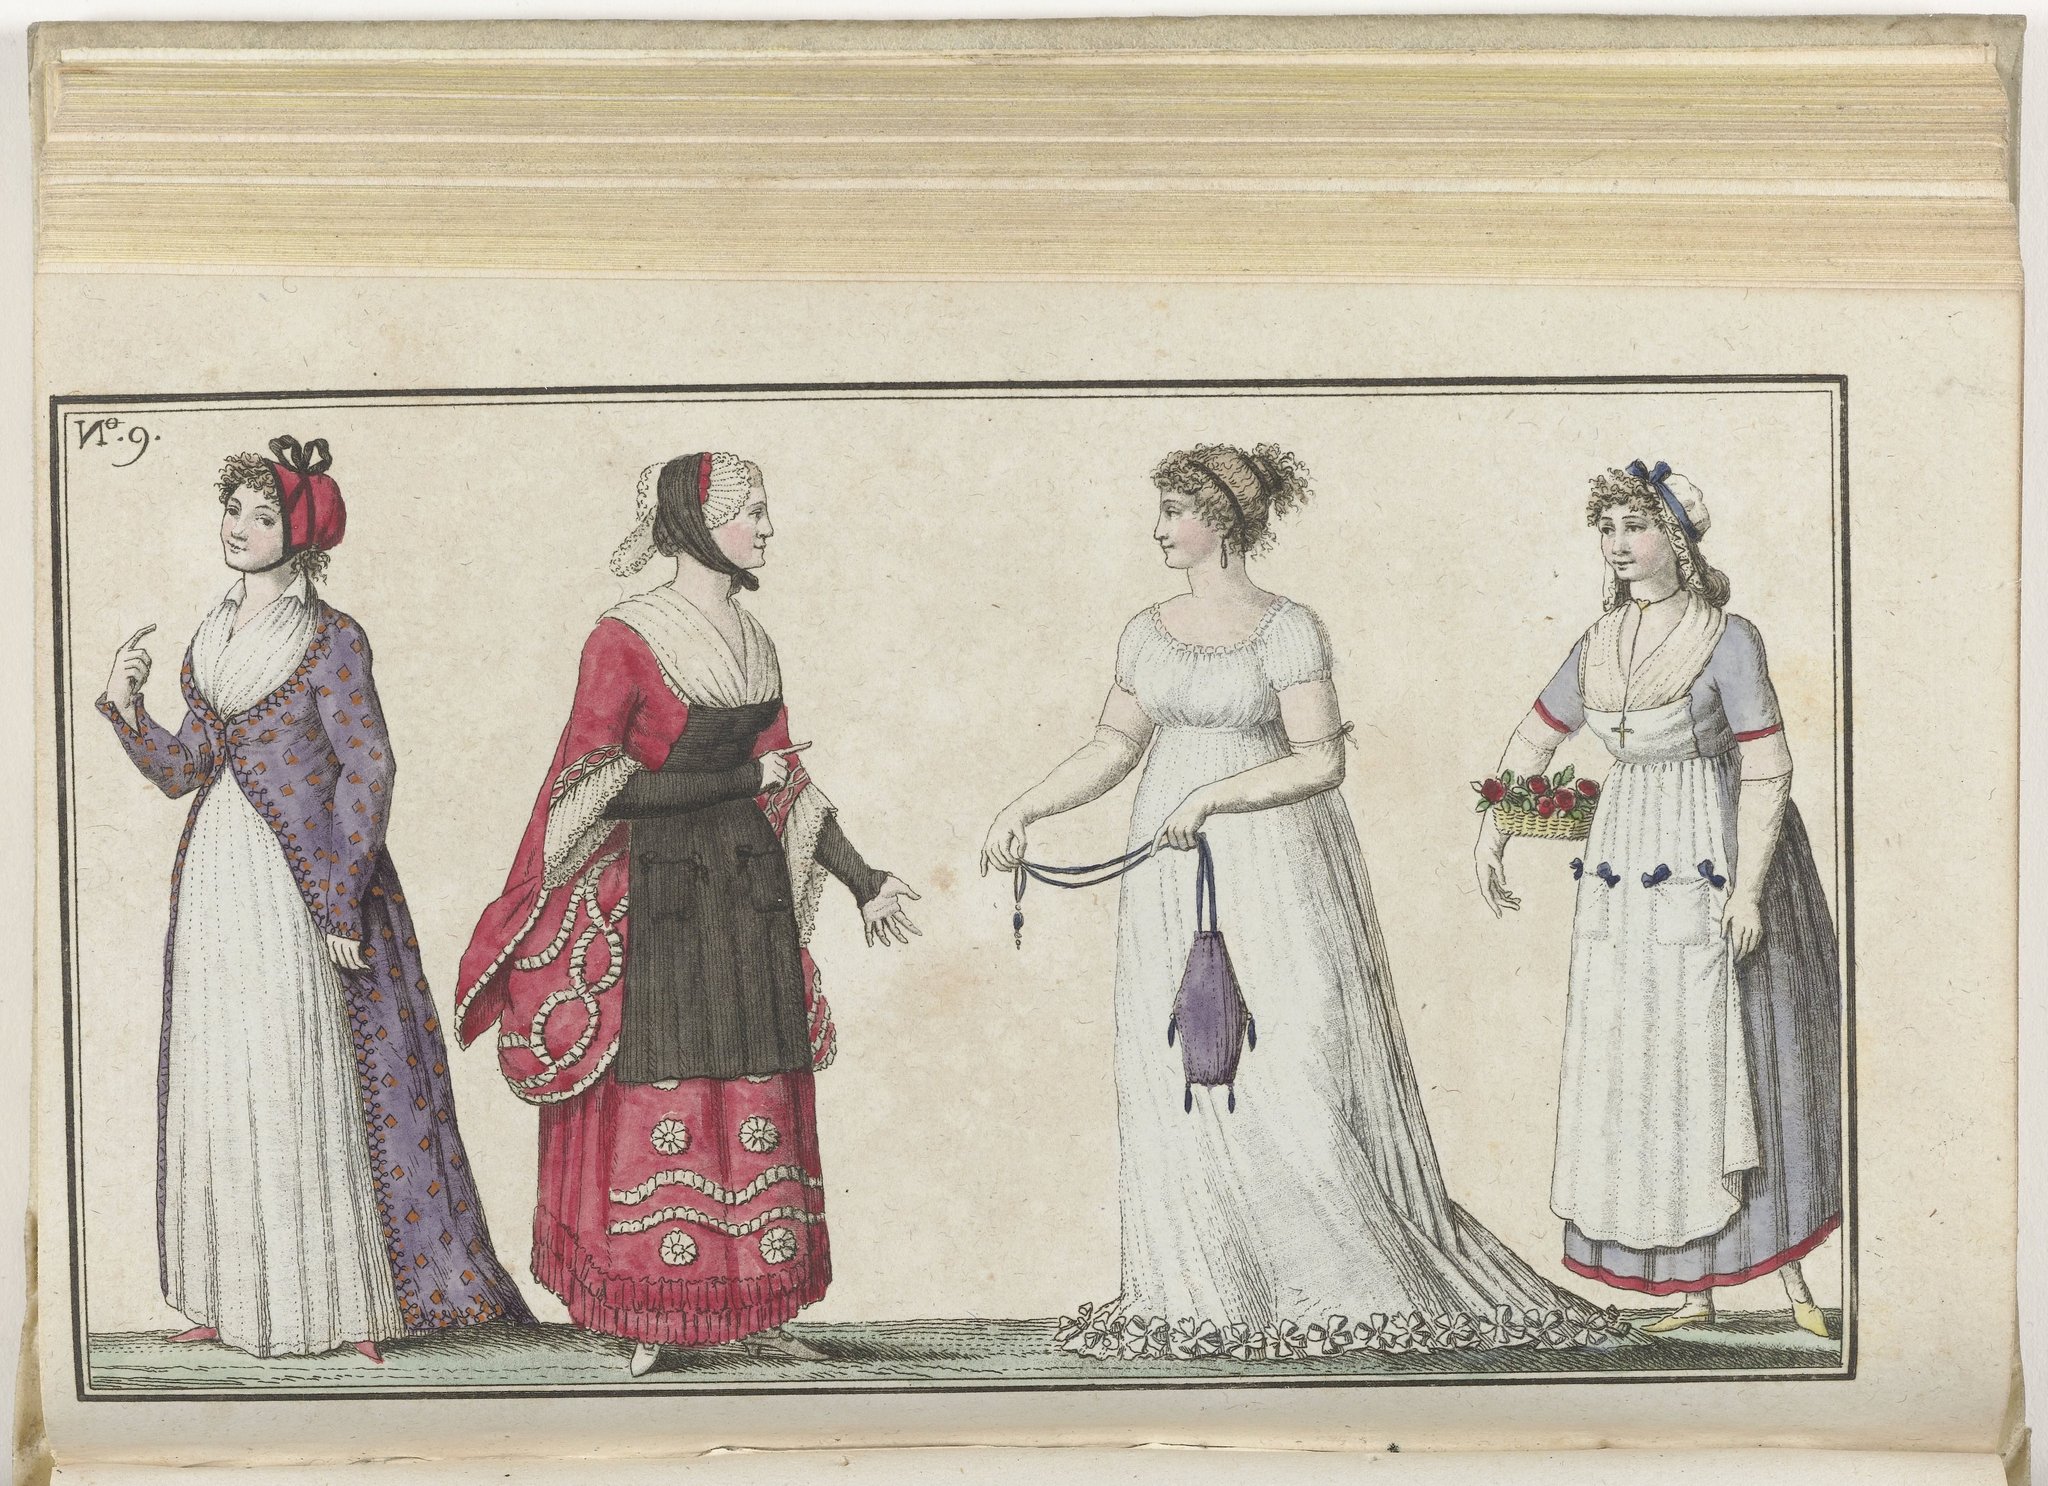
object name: fashion print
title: Le Mois, Journal historique, littéraire et critique avec figures, Tome 3, An. 8 (1799-1800)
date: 1799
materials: paper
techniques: etching, hand coloring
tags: fashion plates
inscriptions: inscription: ‘No. 9’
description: Prent uit het tijdschrift Le Mois : Journal historique, littéraire et critique avec figures, An 7 en 8 (1798-1800).